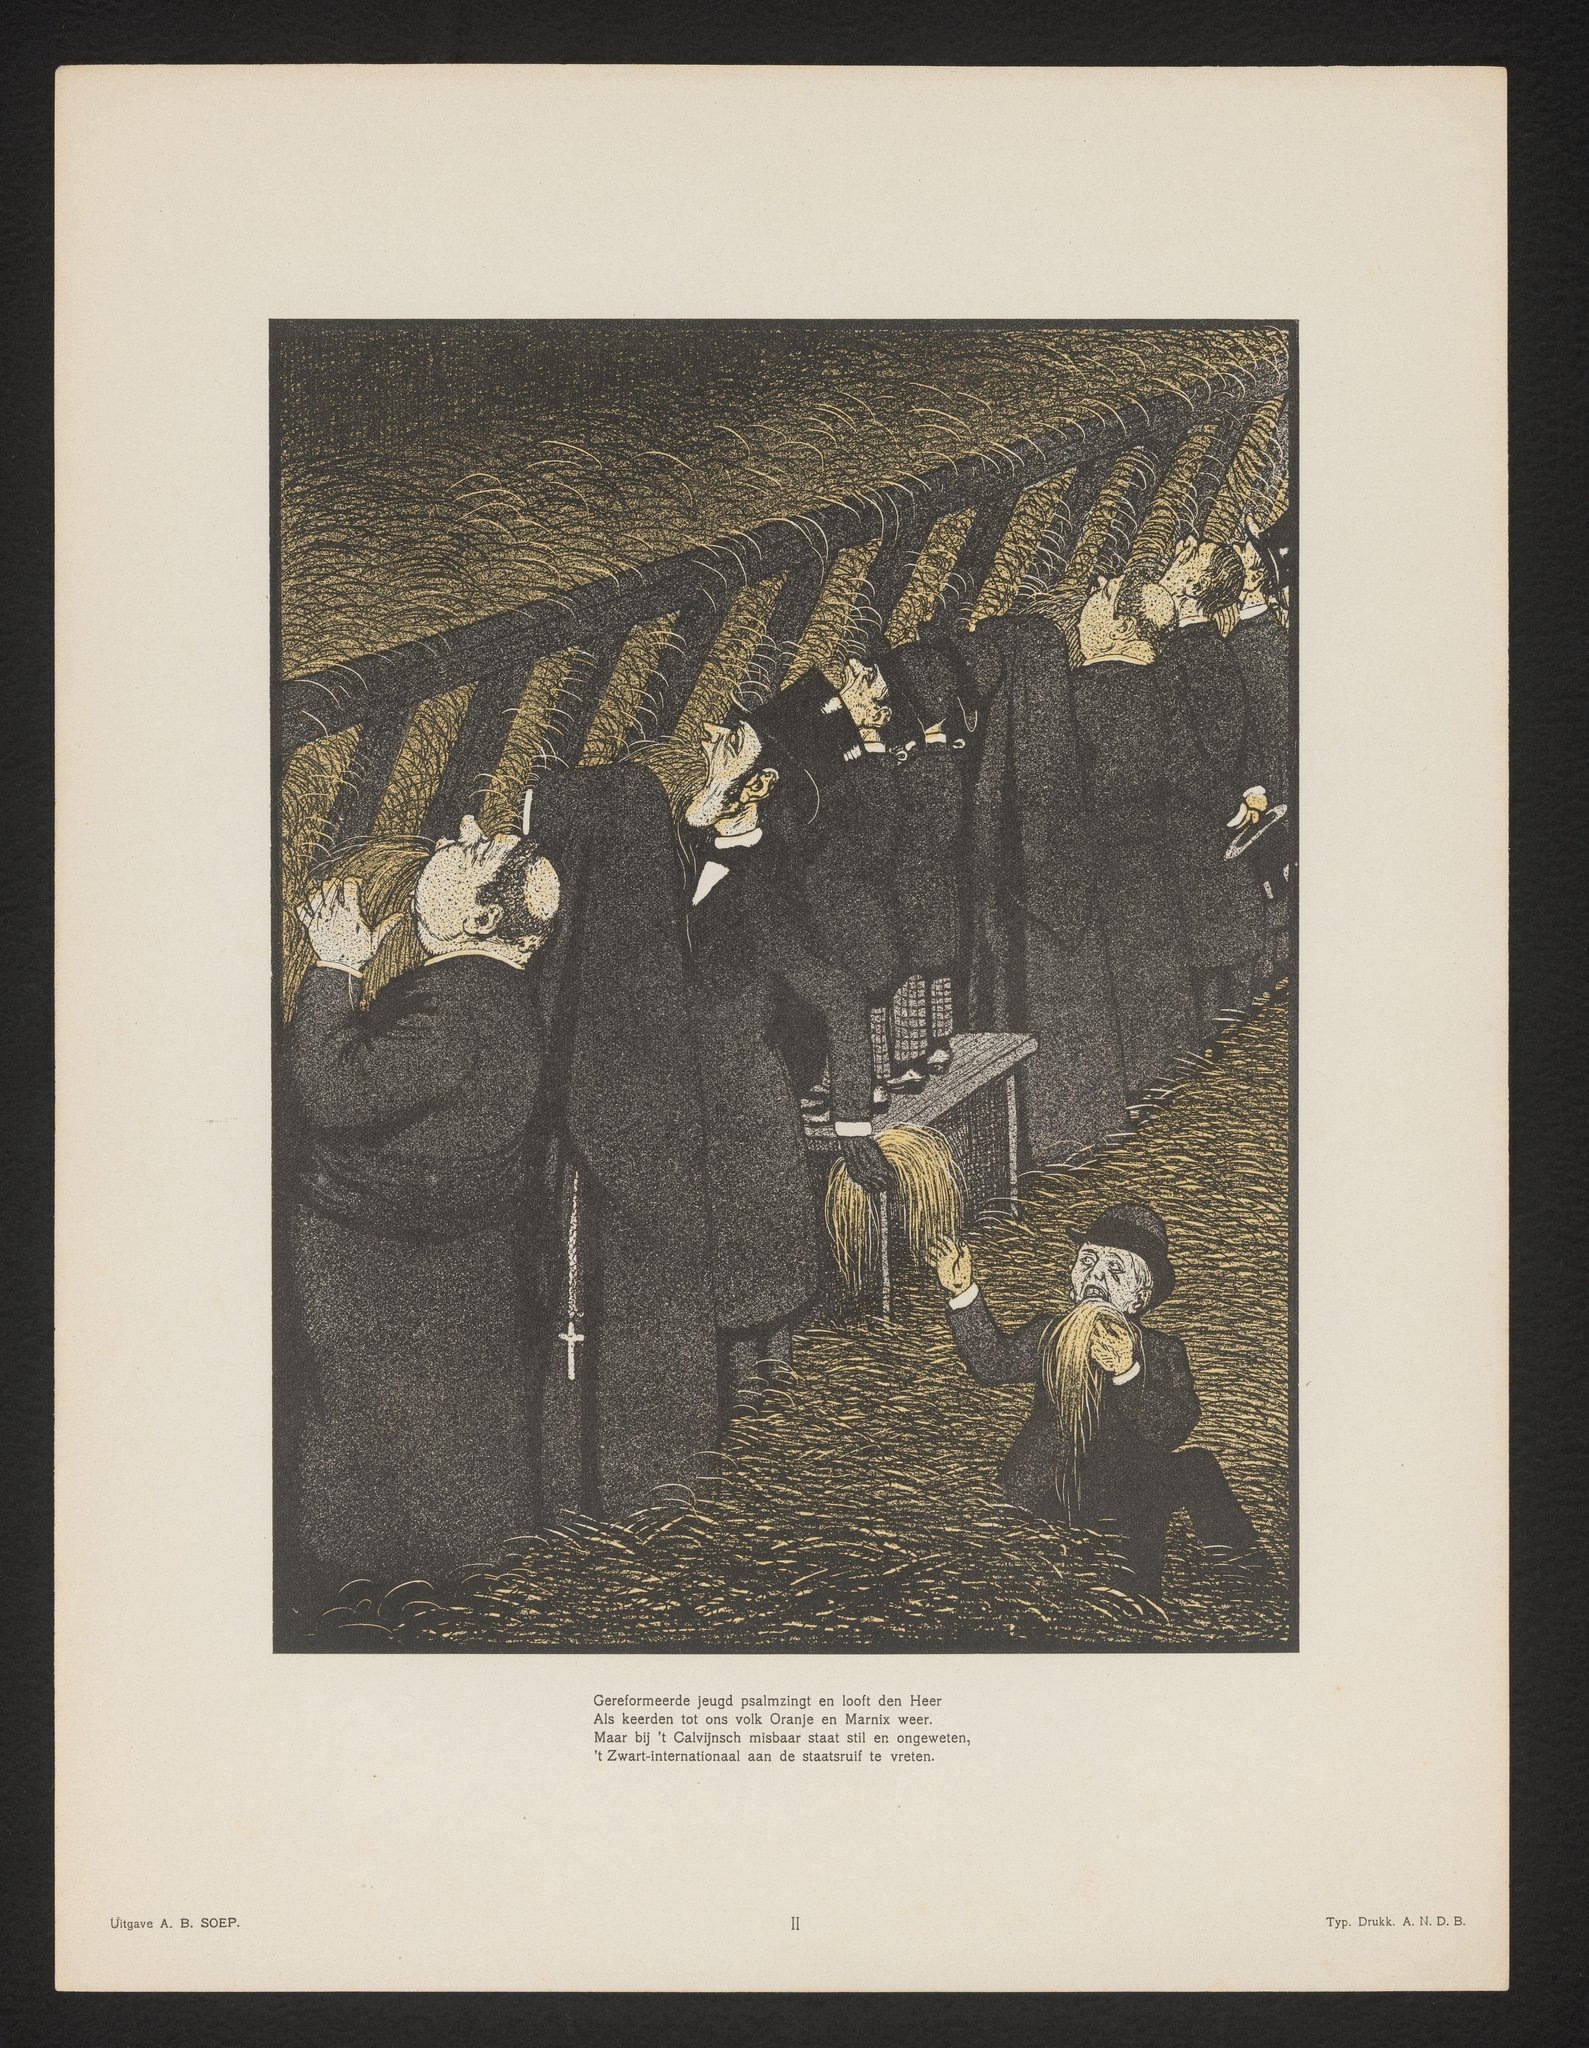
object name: print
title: Katholieken aan de staatsruif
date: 1905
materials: paper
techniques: autotype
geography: amsterdam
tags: protestant churches and denominations, agricultural products and by-products: hay, roman catholic church, political caricatures and satires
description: Terwijl de katholieken hooi eten uit de staatsruif, krijgt de gereformeerde jeugd slechts een handje hooi toebedeeld. Met vierregelig onderschrift. Onderdeel van de prentserie 'Onder Zwart Regime'.